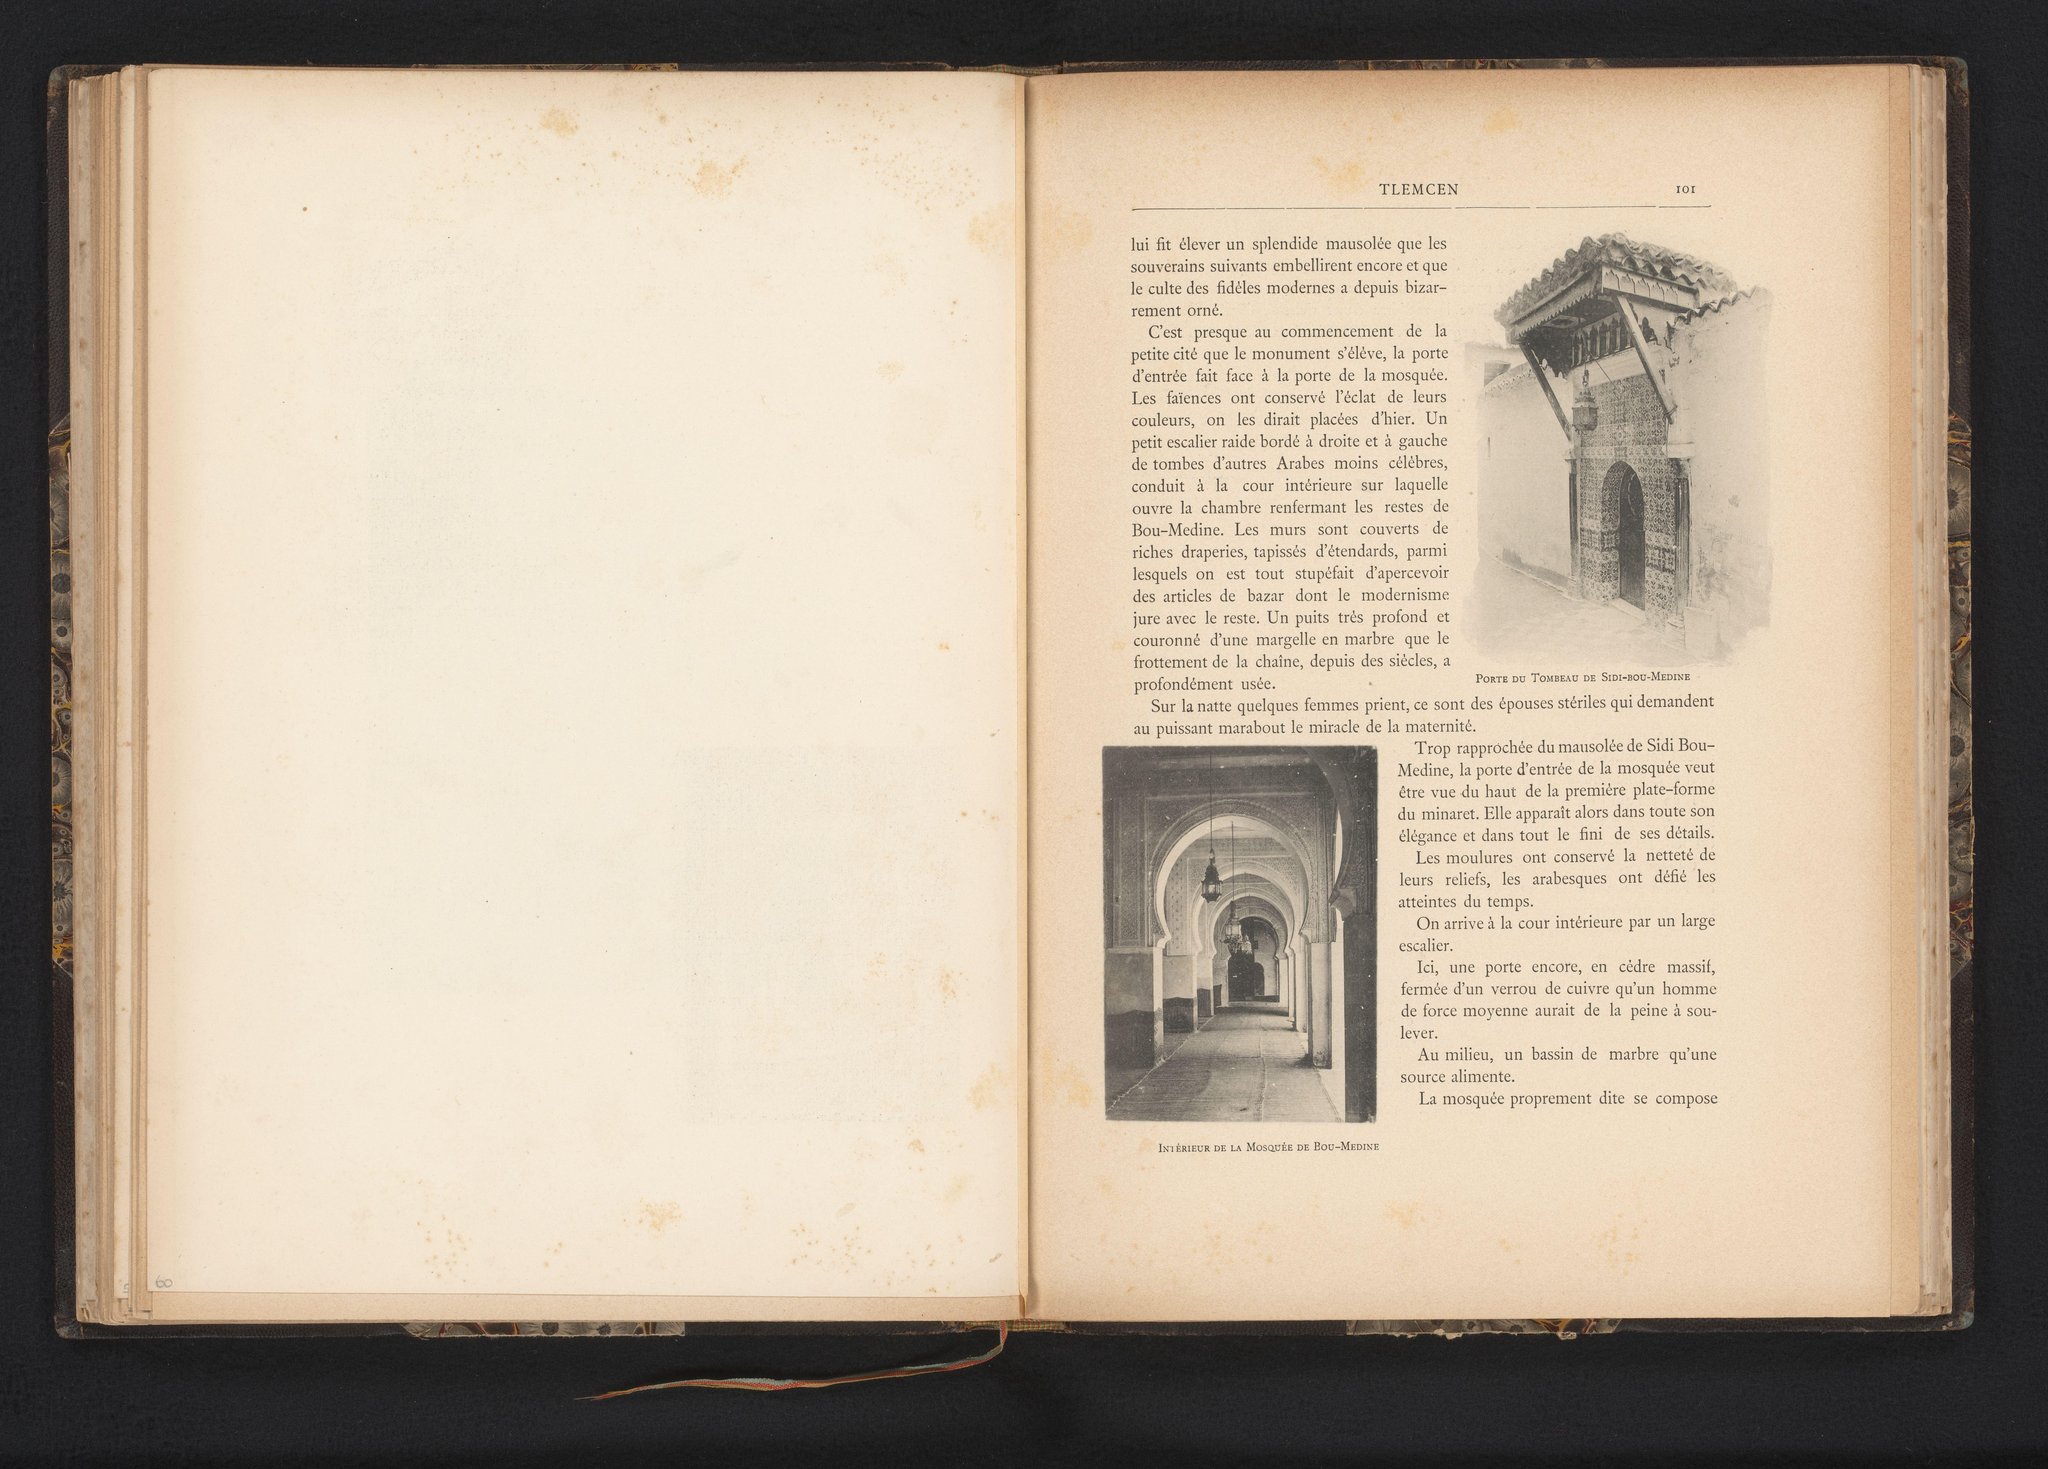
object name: photomechanical print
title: Intérieur de la Mosquée de Bou-Medine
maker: jules gervais-courtellemont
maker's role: fotograaf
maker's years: 1863-1931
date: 1888-1893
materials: paper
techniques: photograph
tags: temple, shrine ~ islam, mohammedanism